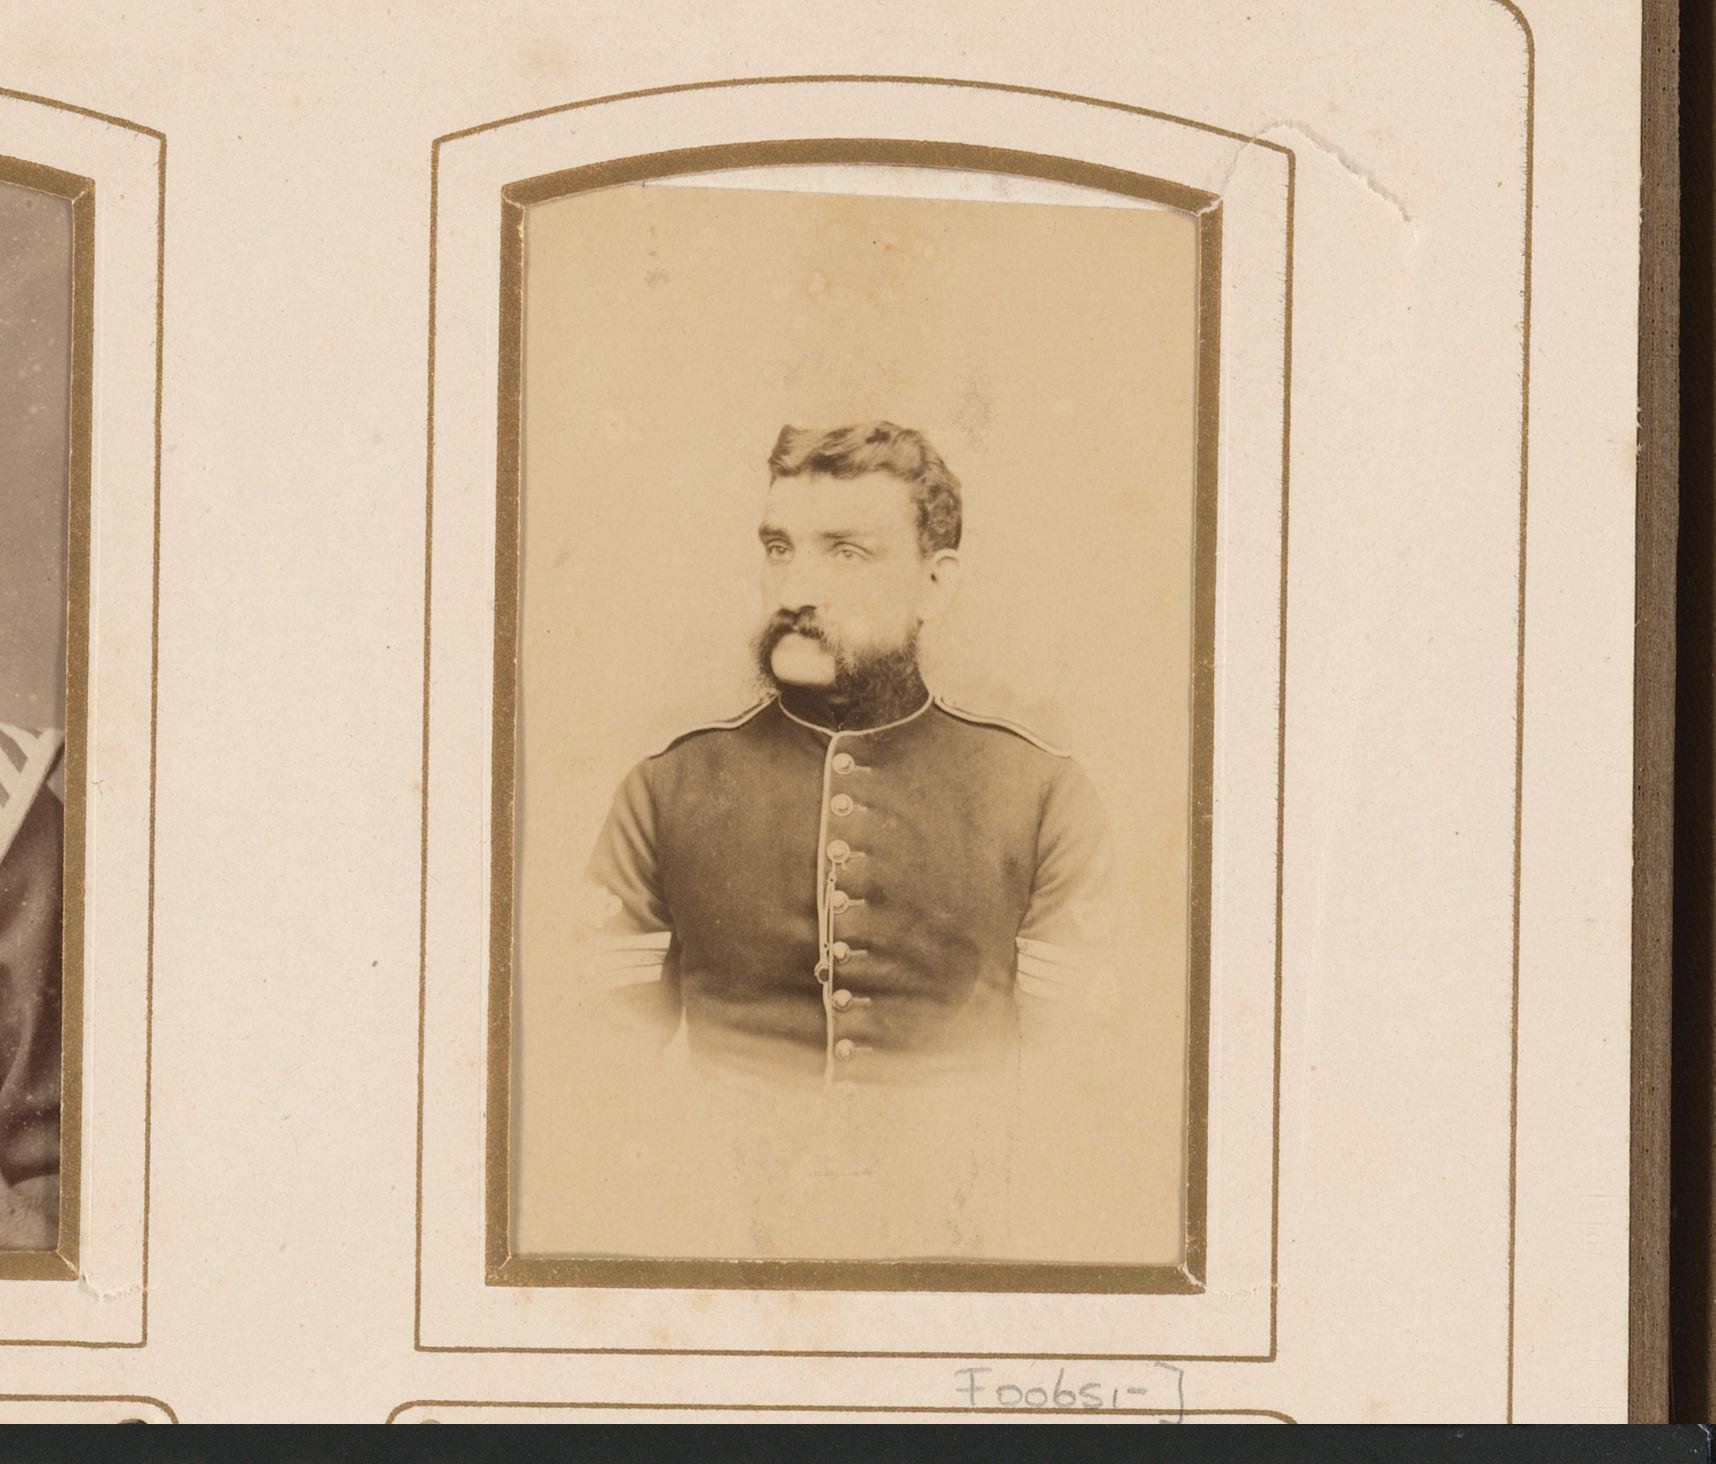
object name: photograph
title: Portret van een man in een maritiem uniform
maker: Anonymous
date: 1880-1915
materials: cardboard, photographic support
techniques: albumen print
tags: adult man, historical persons, seaman, (military) uniforms